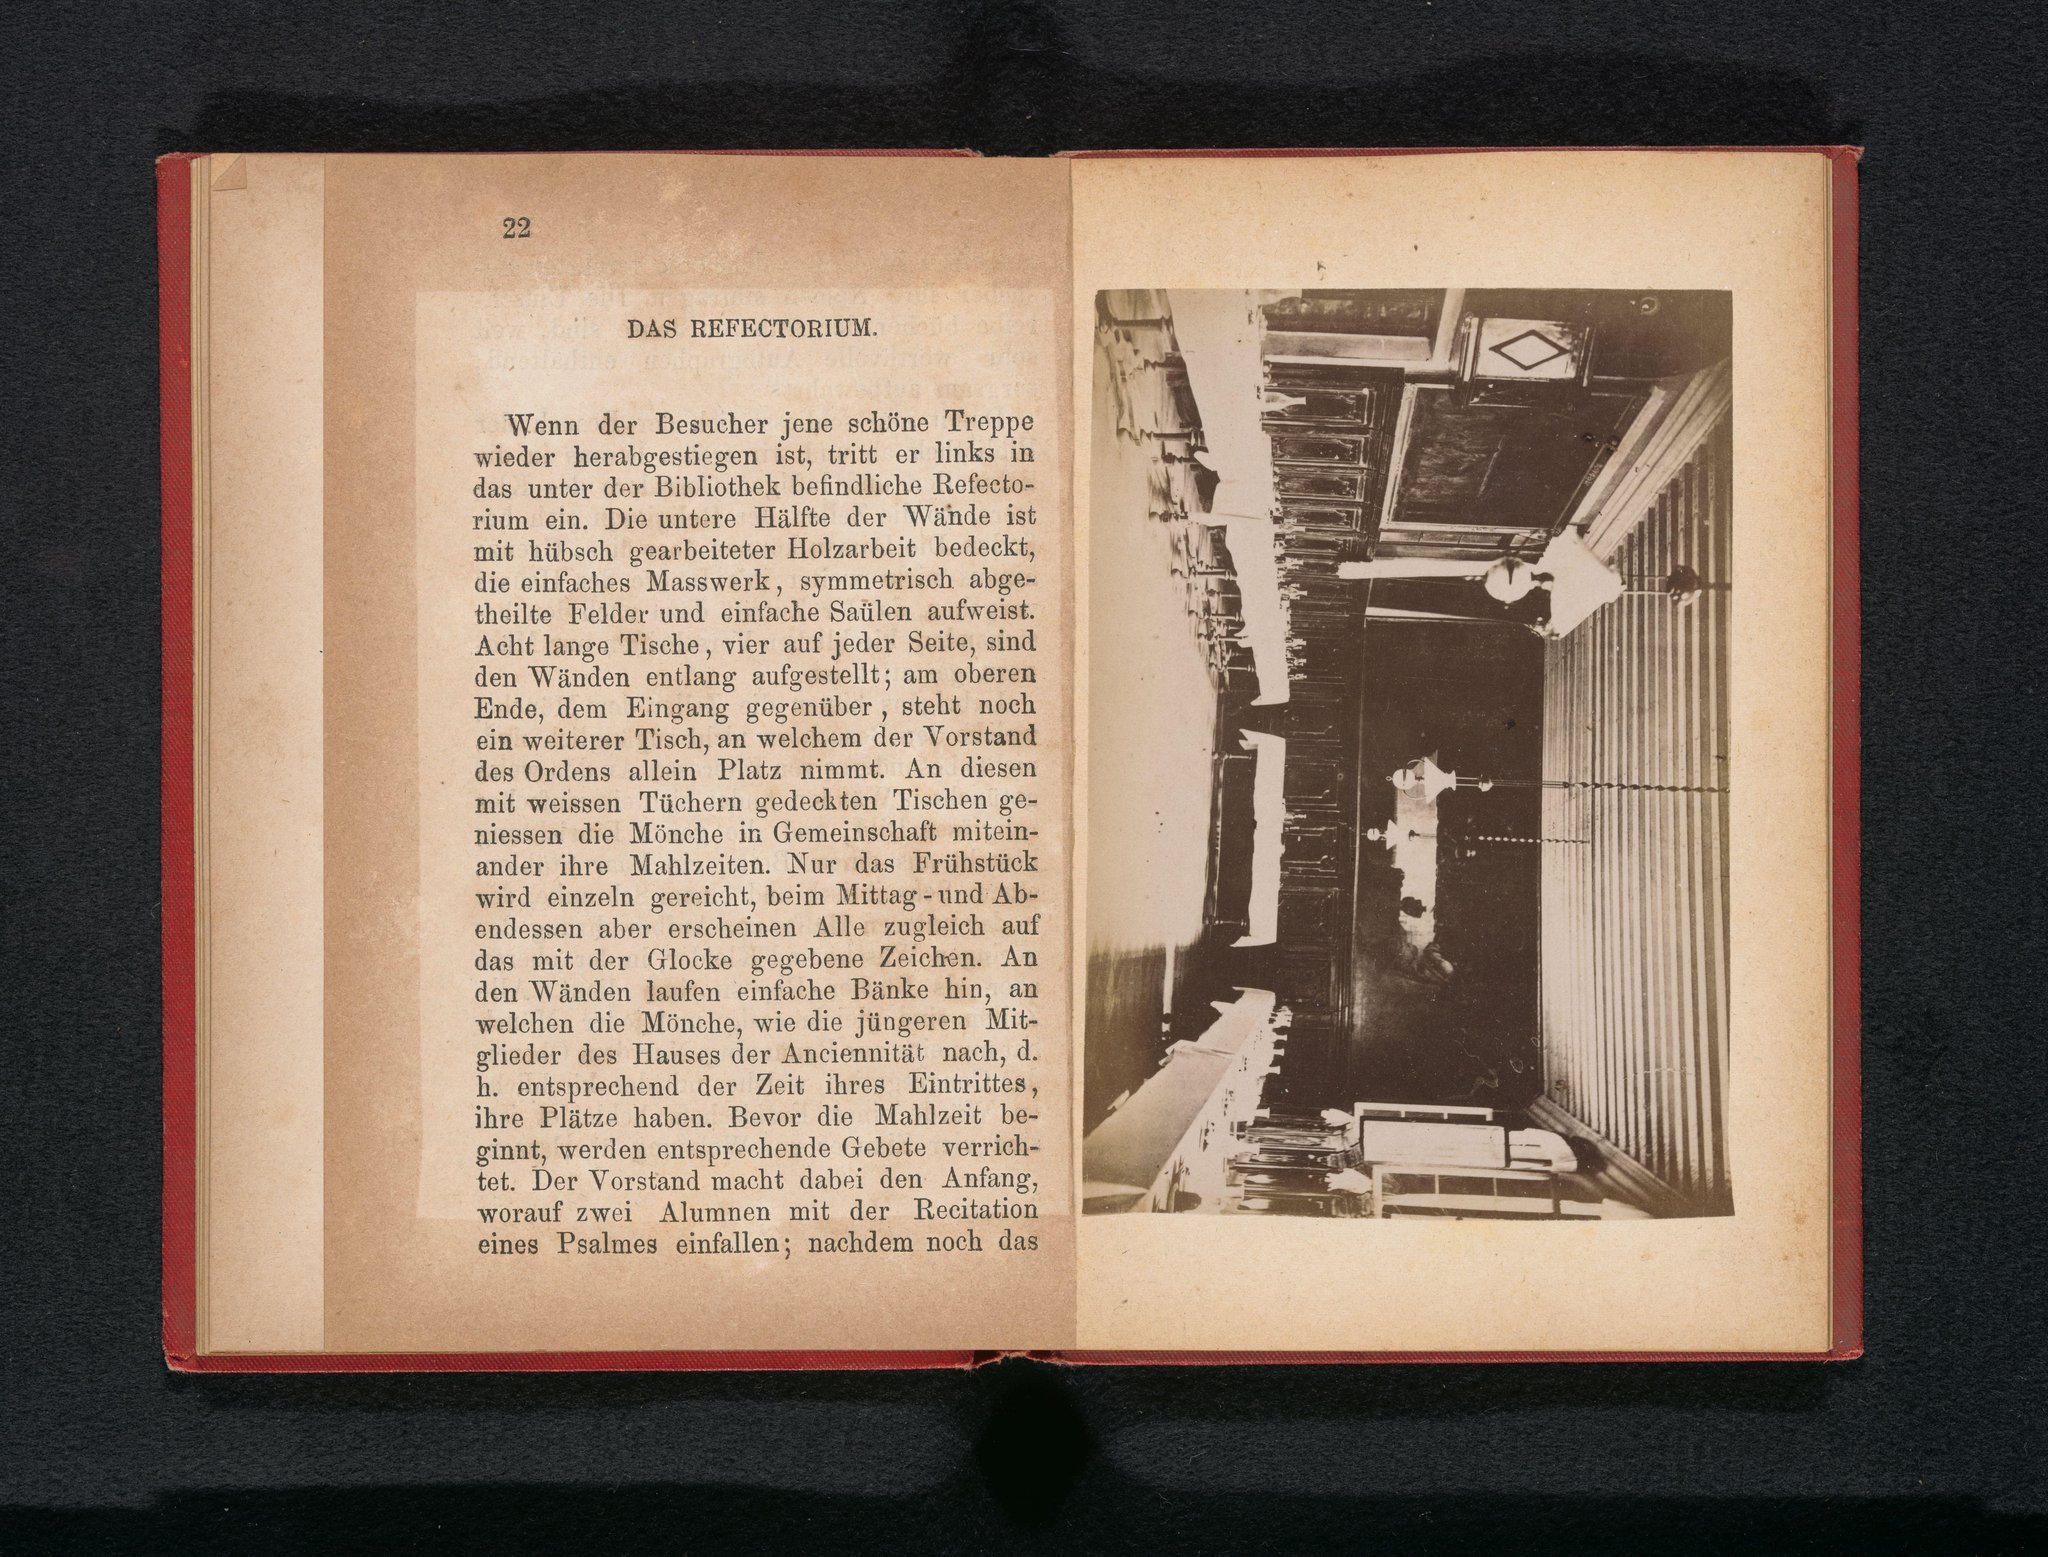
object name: page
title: Refectory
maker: Anonymous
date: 1870-1880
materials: paper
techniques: albumen print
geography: san lazzaro degli armeni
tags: refectory ~ monastery